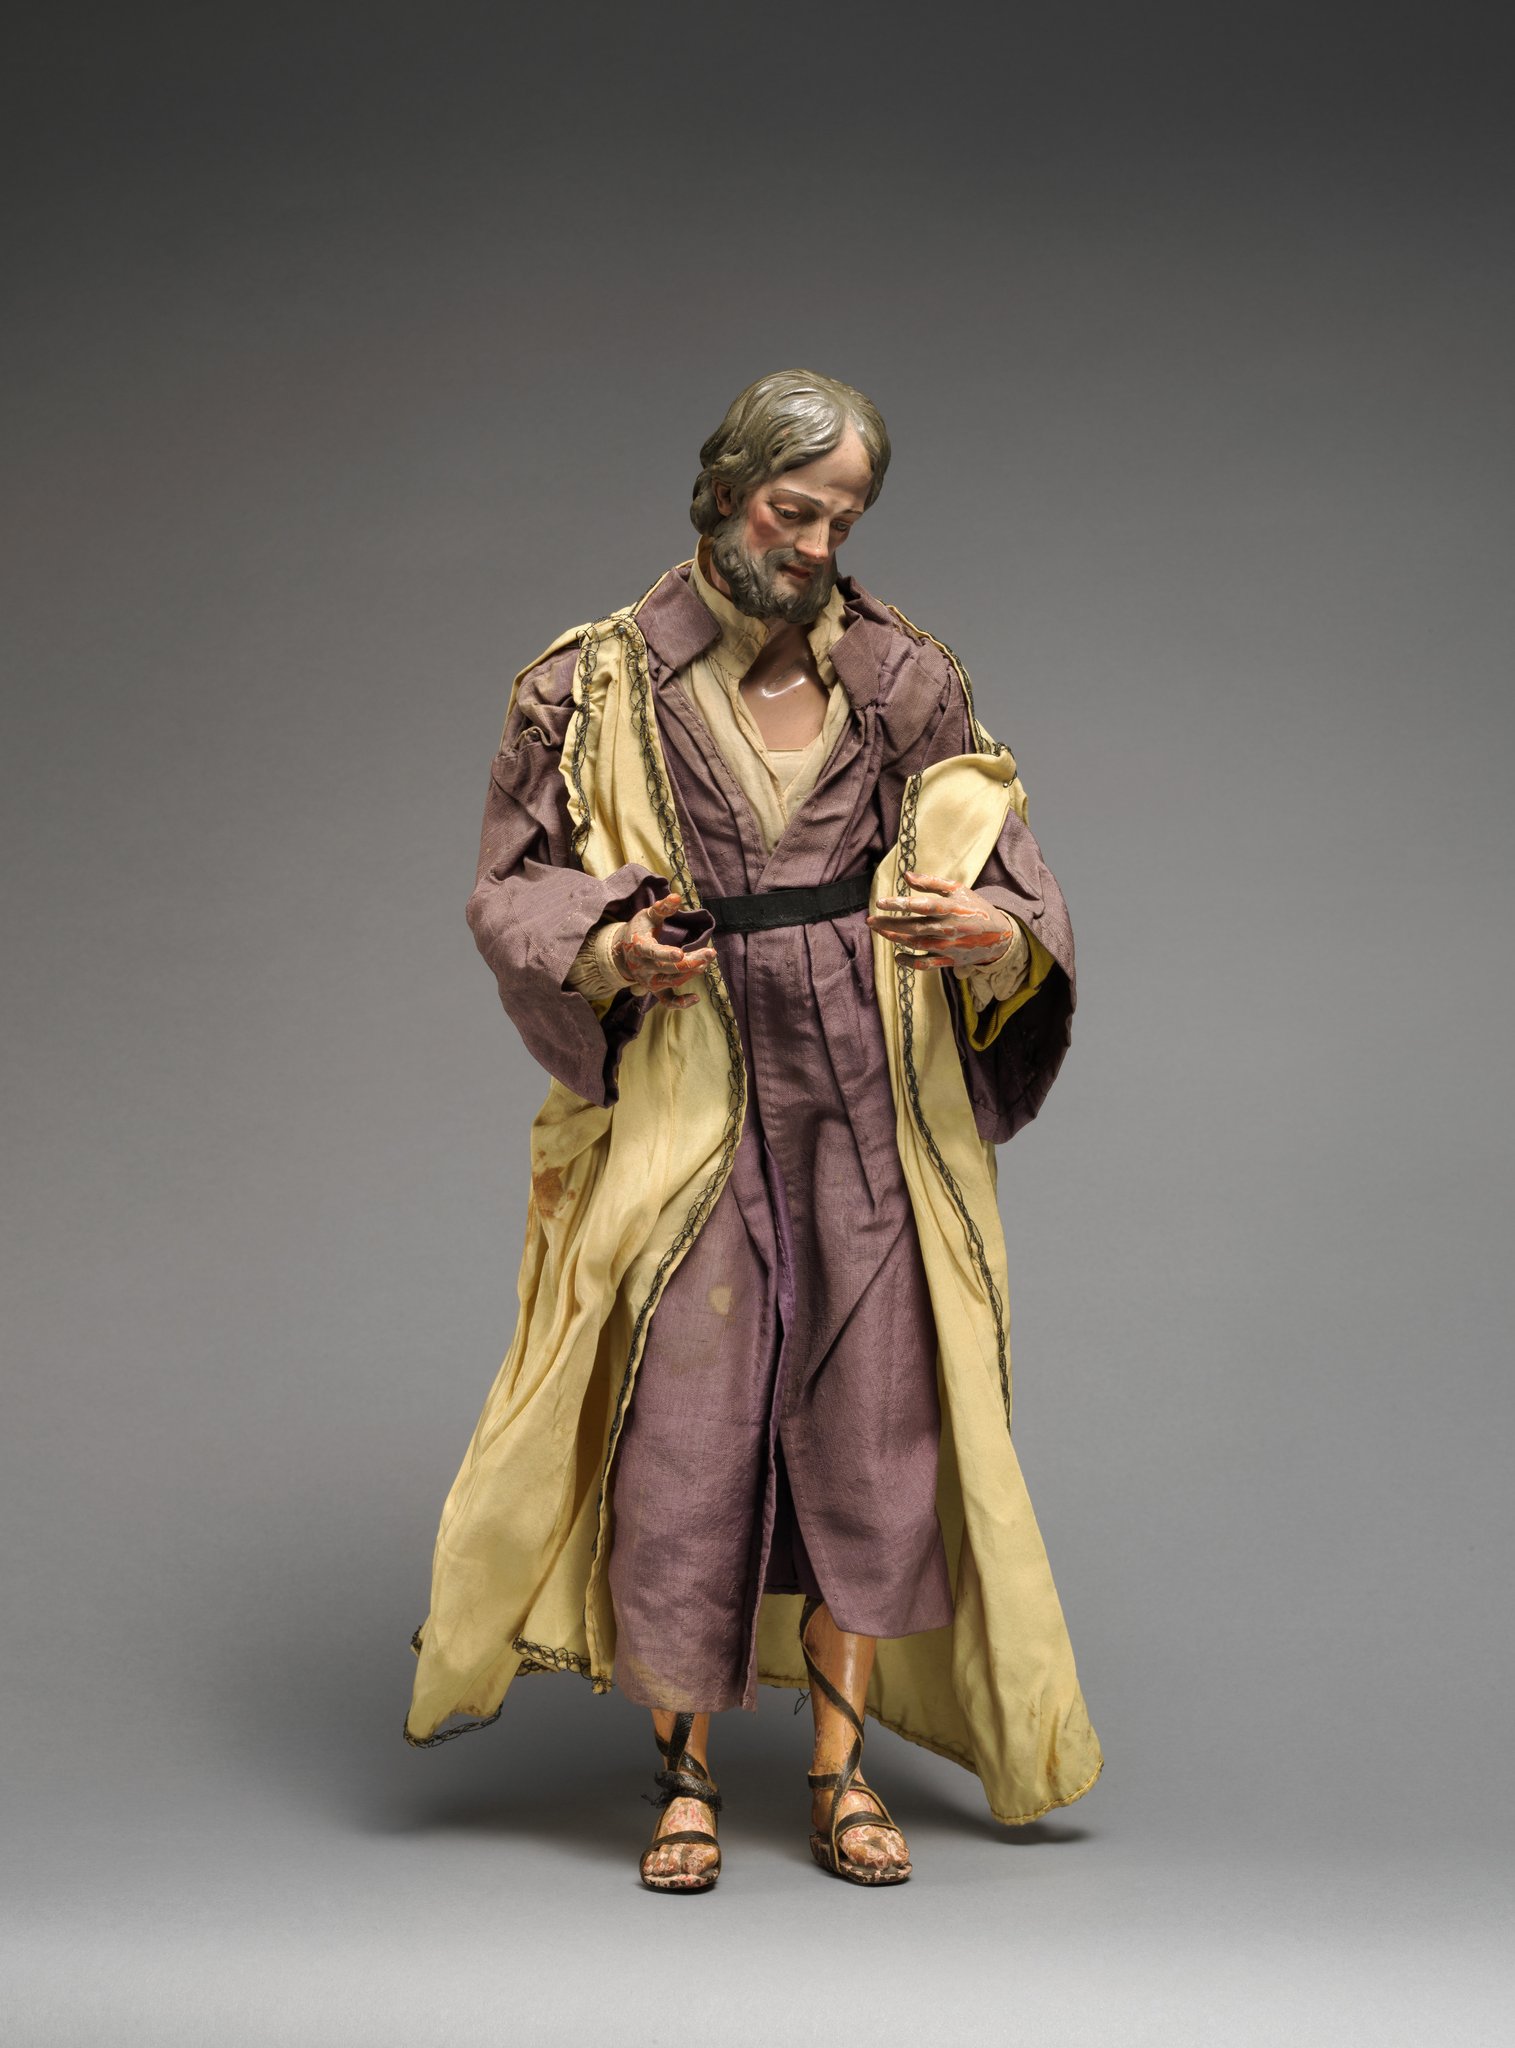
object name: crèche figure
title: Large “Joseph” with purple and yellow robes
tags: men,saint joseph